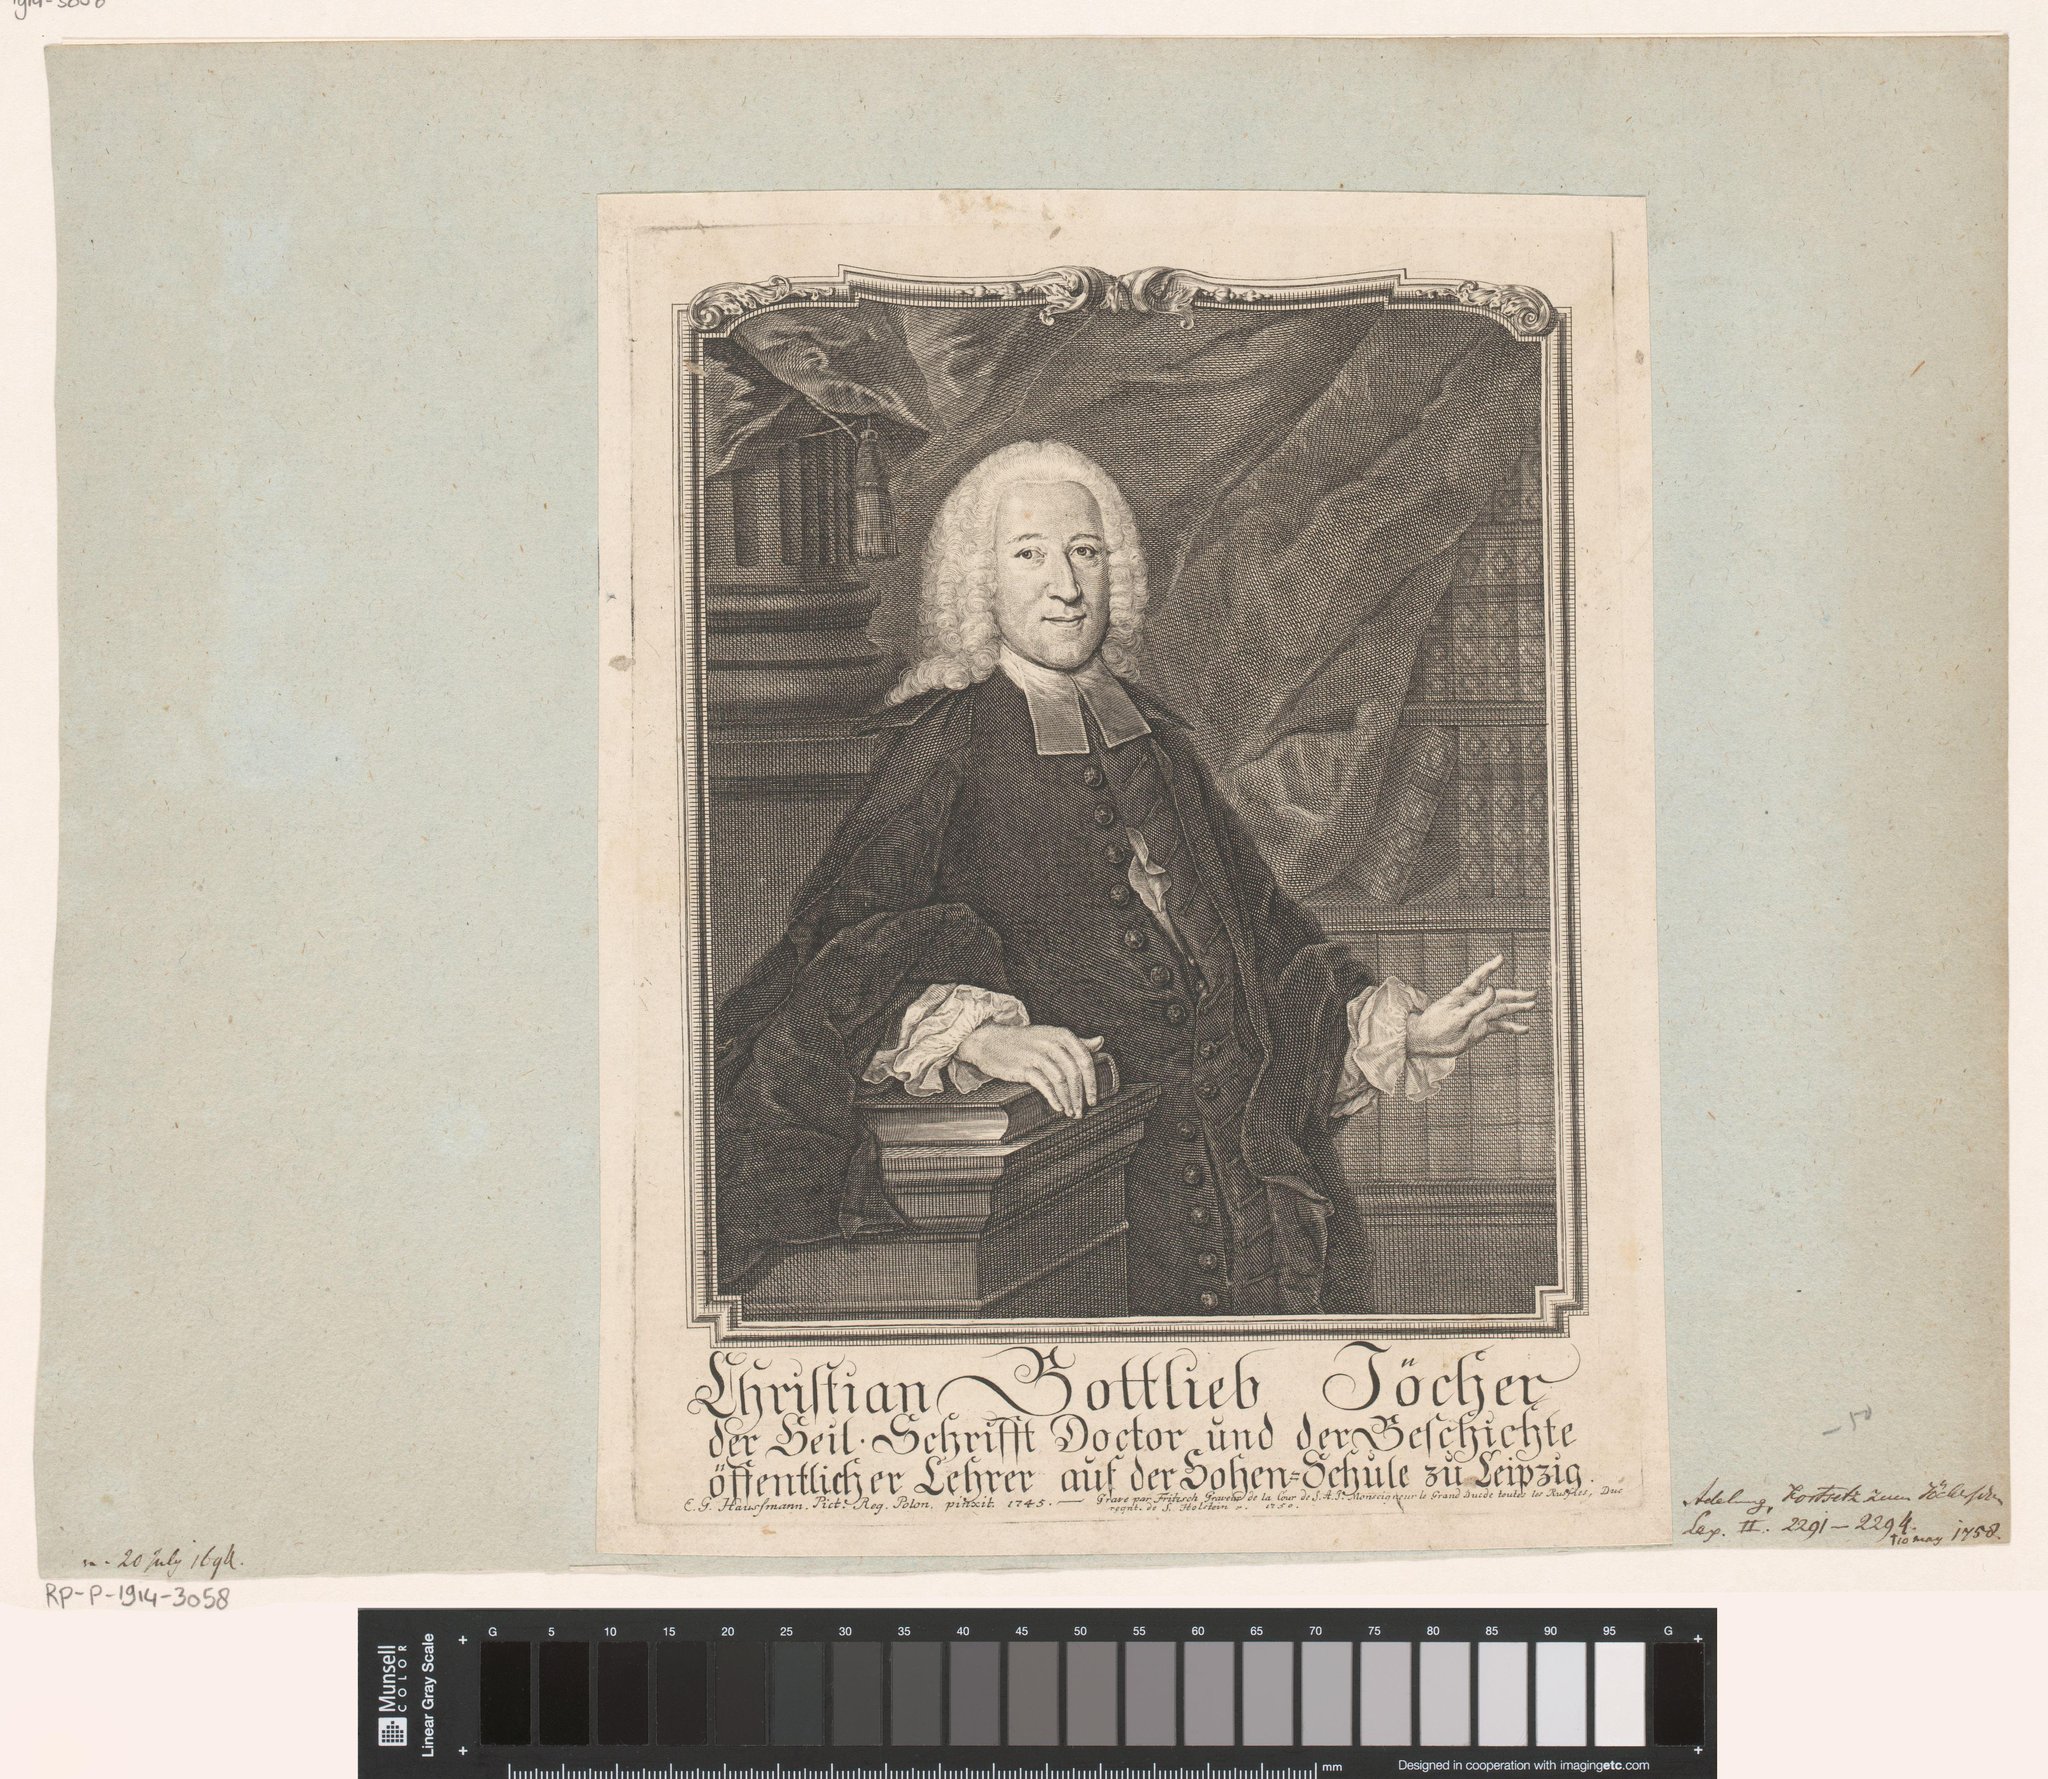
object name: print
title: Portret van Christian Gottlieb Jöcher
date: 1745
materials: paper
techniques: engraving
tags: bookshelves, historical persons, book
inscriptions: collector's mark: Lugt 2228